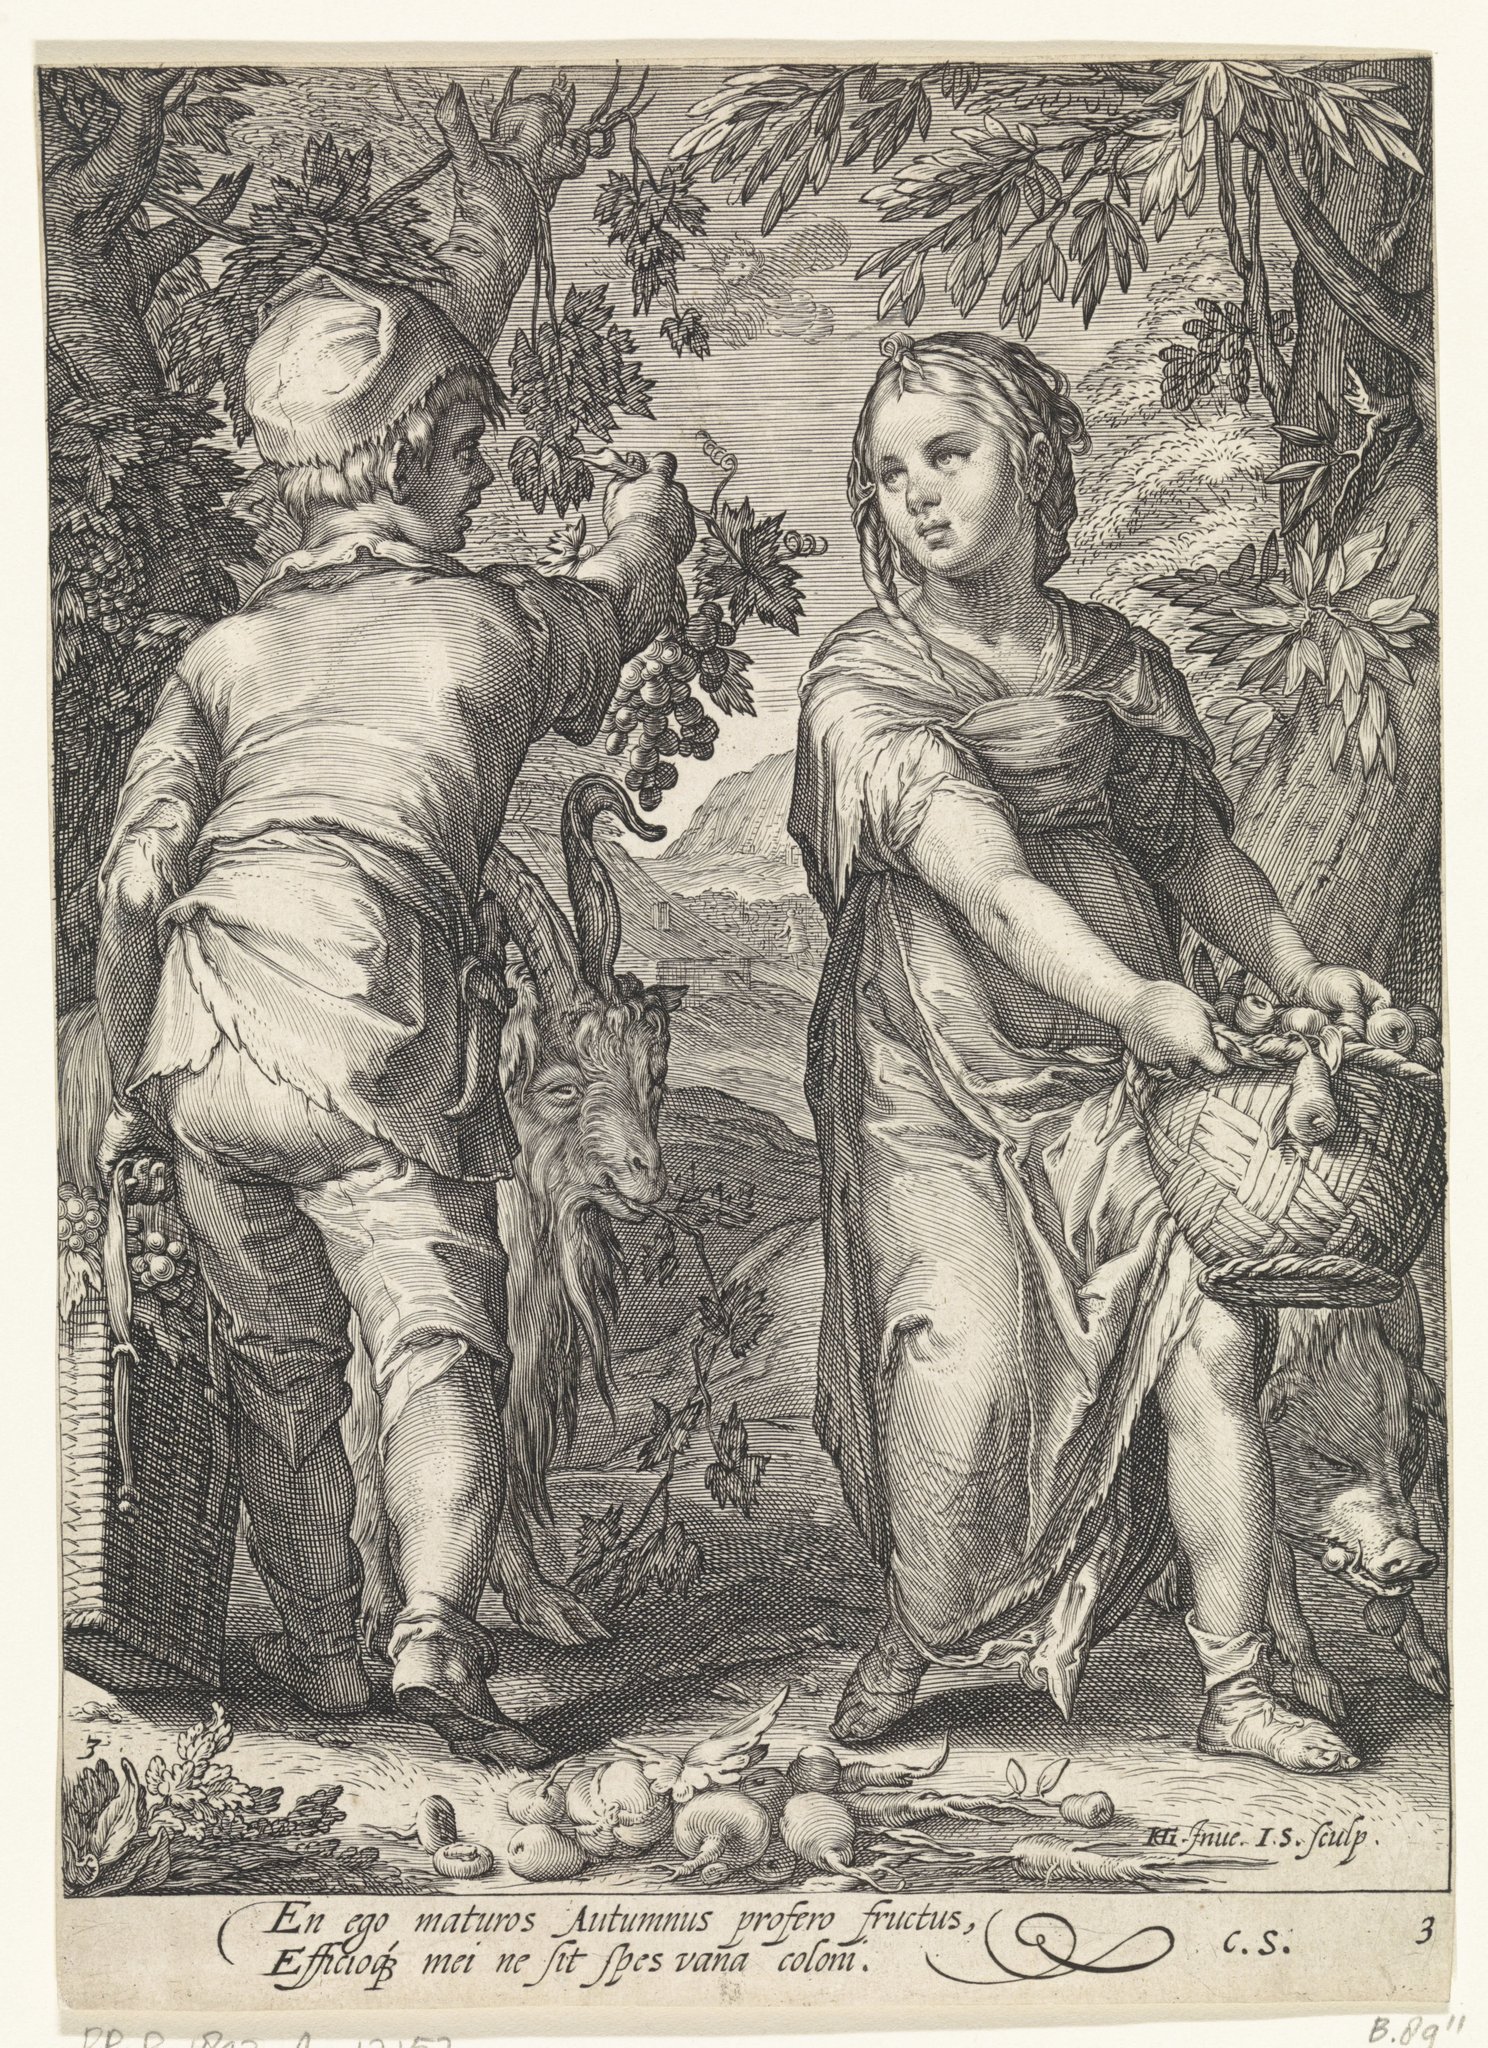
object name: print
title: De vier seizoenen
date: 1601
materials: paper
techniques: engraving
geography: northern netherlands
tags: fruit-tree culture; fruit harvest, boar (male pig), he-goat, billy-goat, vintage, grape harvest, autumn, fall, 'autumnus'; 'autunno' (ripa)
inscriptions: collector's mark: Lugt 2228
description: Een jongen en een meisje oogsten fruit in het bijzijn van een bok en een zwijn. De jongen plukt druiven, het meisje draagt een mand met peren.